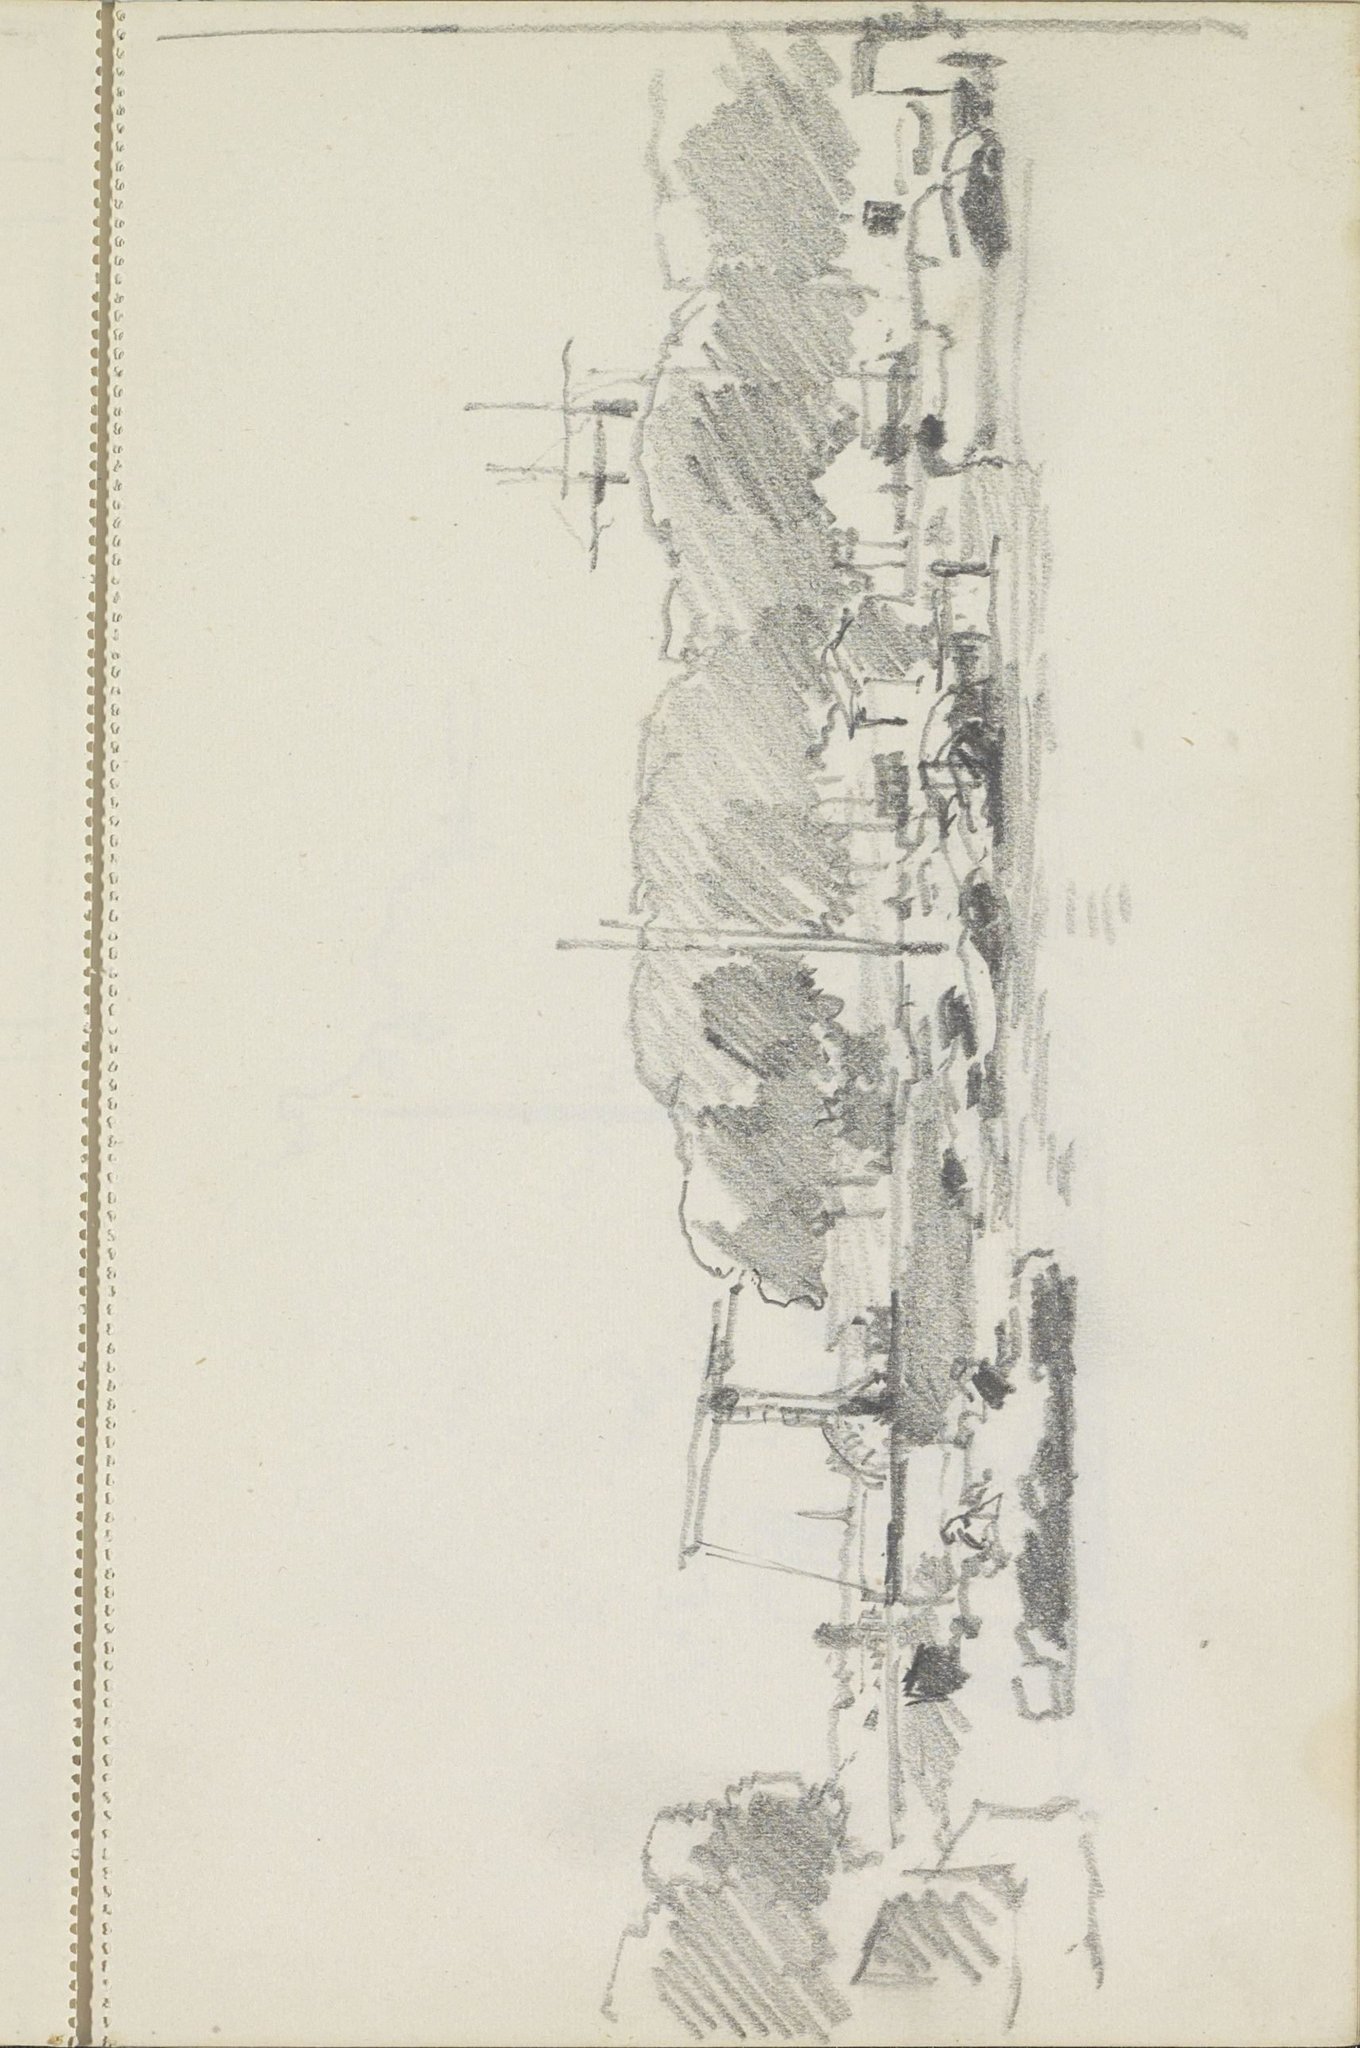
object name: sketchbook leaf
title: Boten op het water bij een ophaalbrug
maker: cornelis vreedenburgh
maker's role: draughtsman, print maker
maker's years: 1880-1946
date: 1890-1946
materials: paper, pencil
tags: landscapes with waters, waterscapes, seascapes (in the temperate zone), bridge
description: Blad 12 recto uit een schetsboek met 50 bladen.